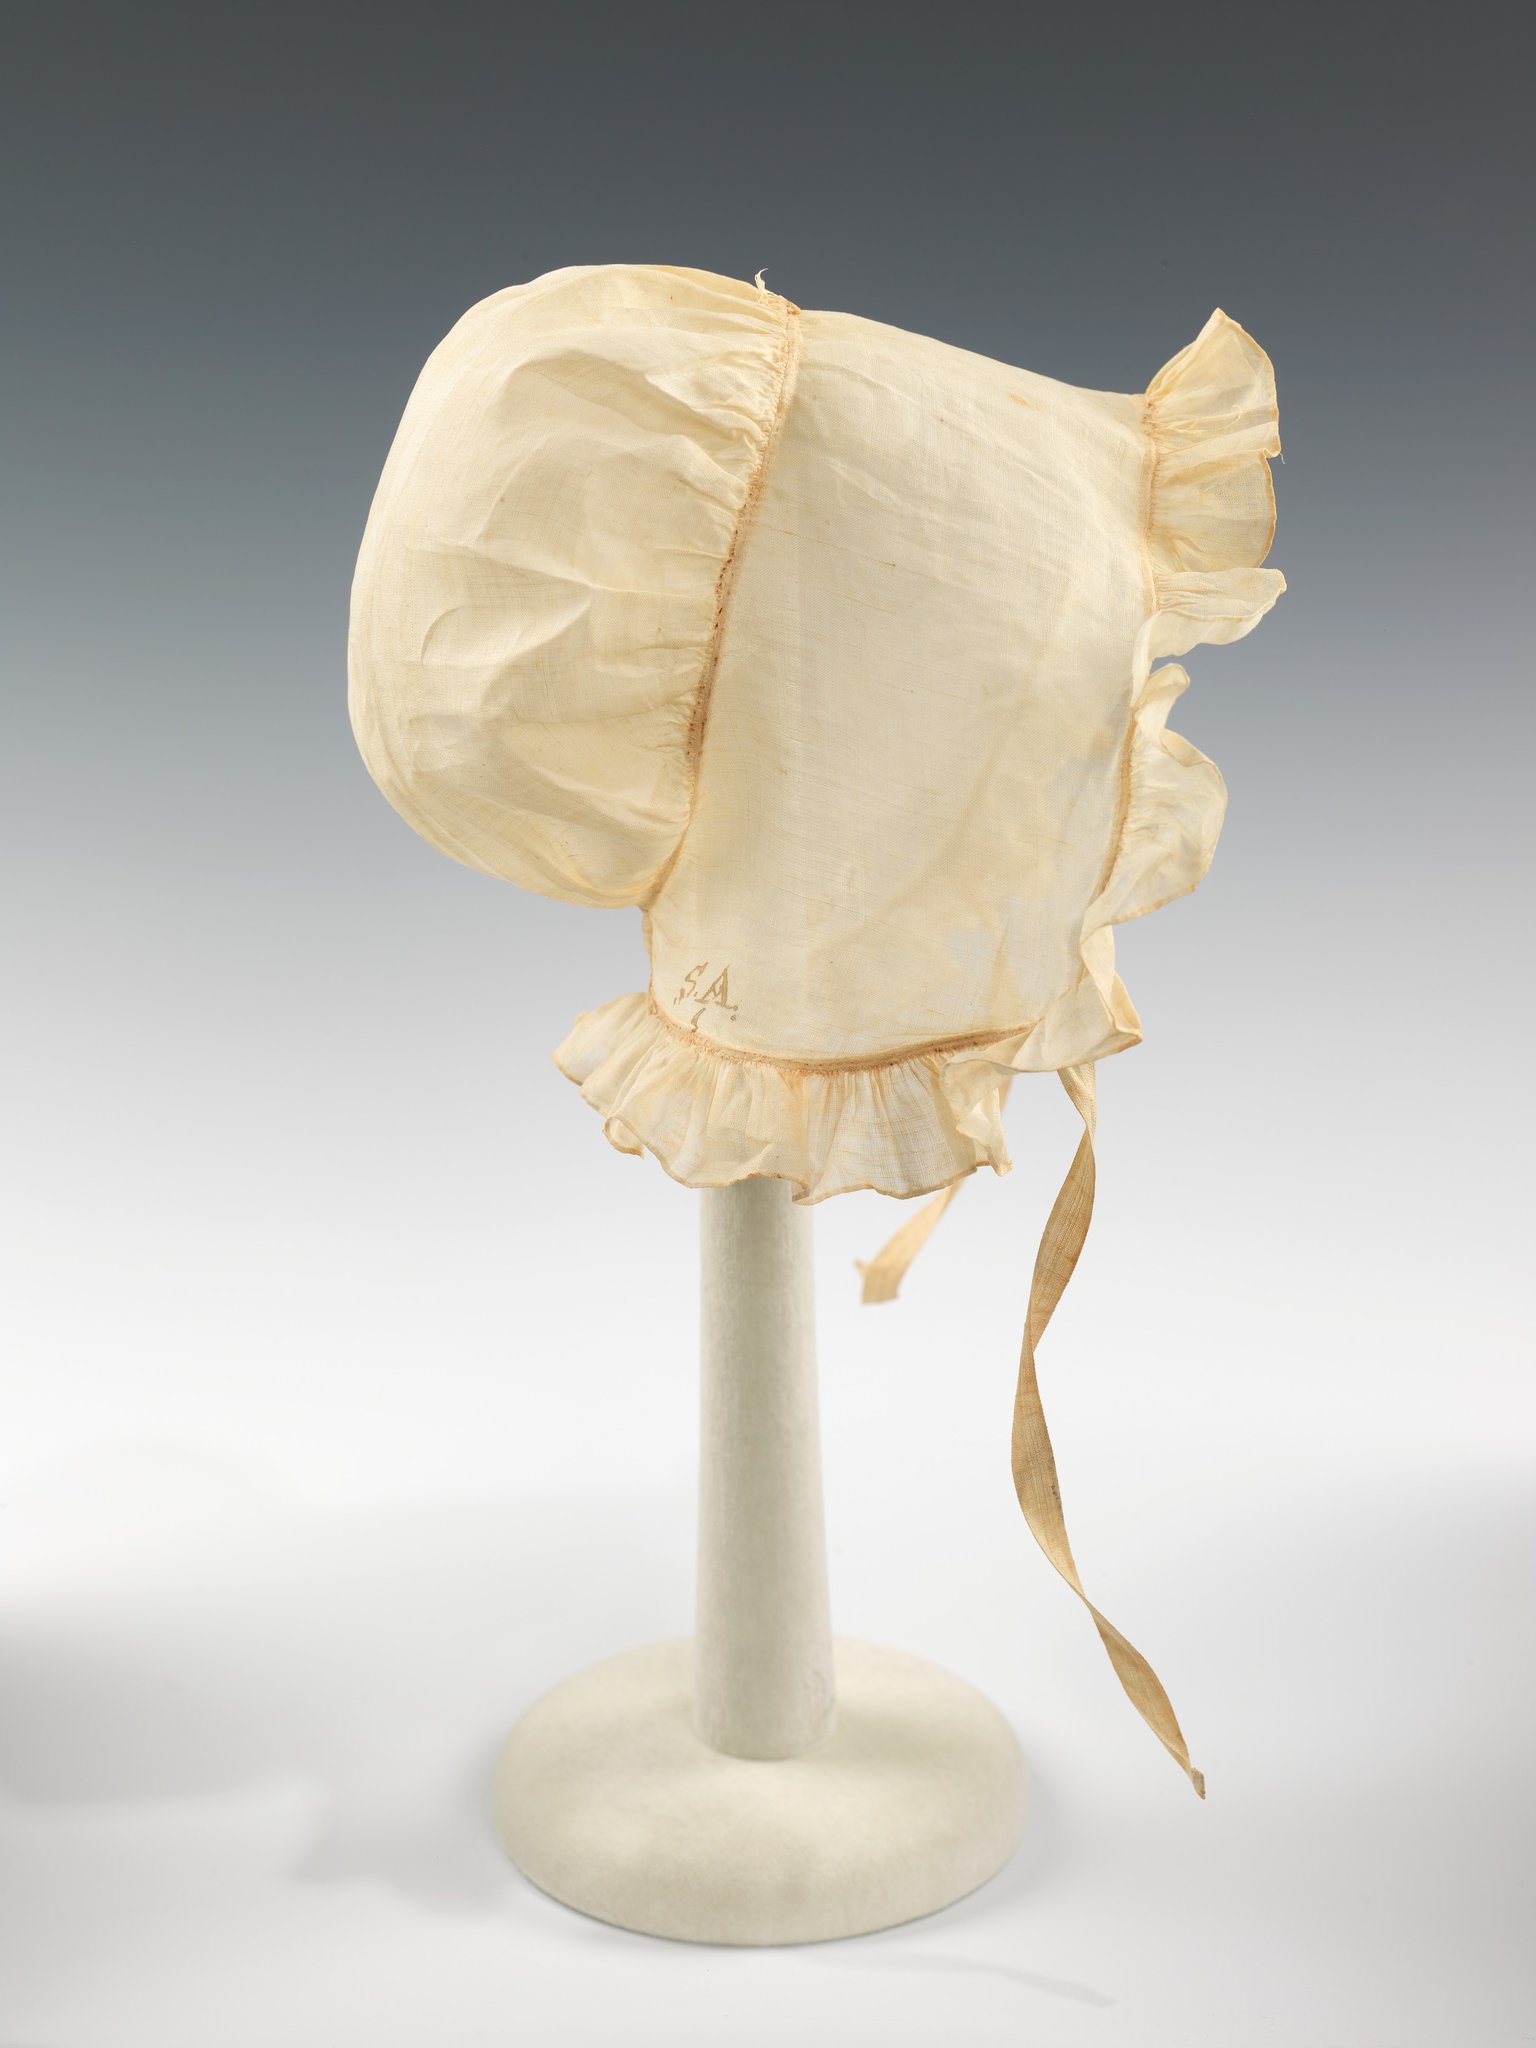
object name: poke bonnet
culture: american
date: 1830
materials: linen